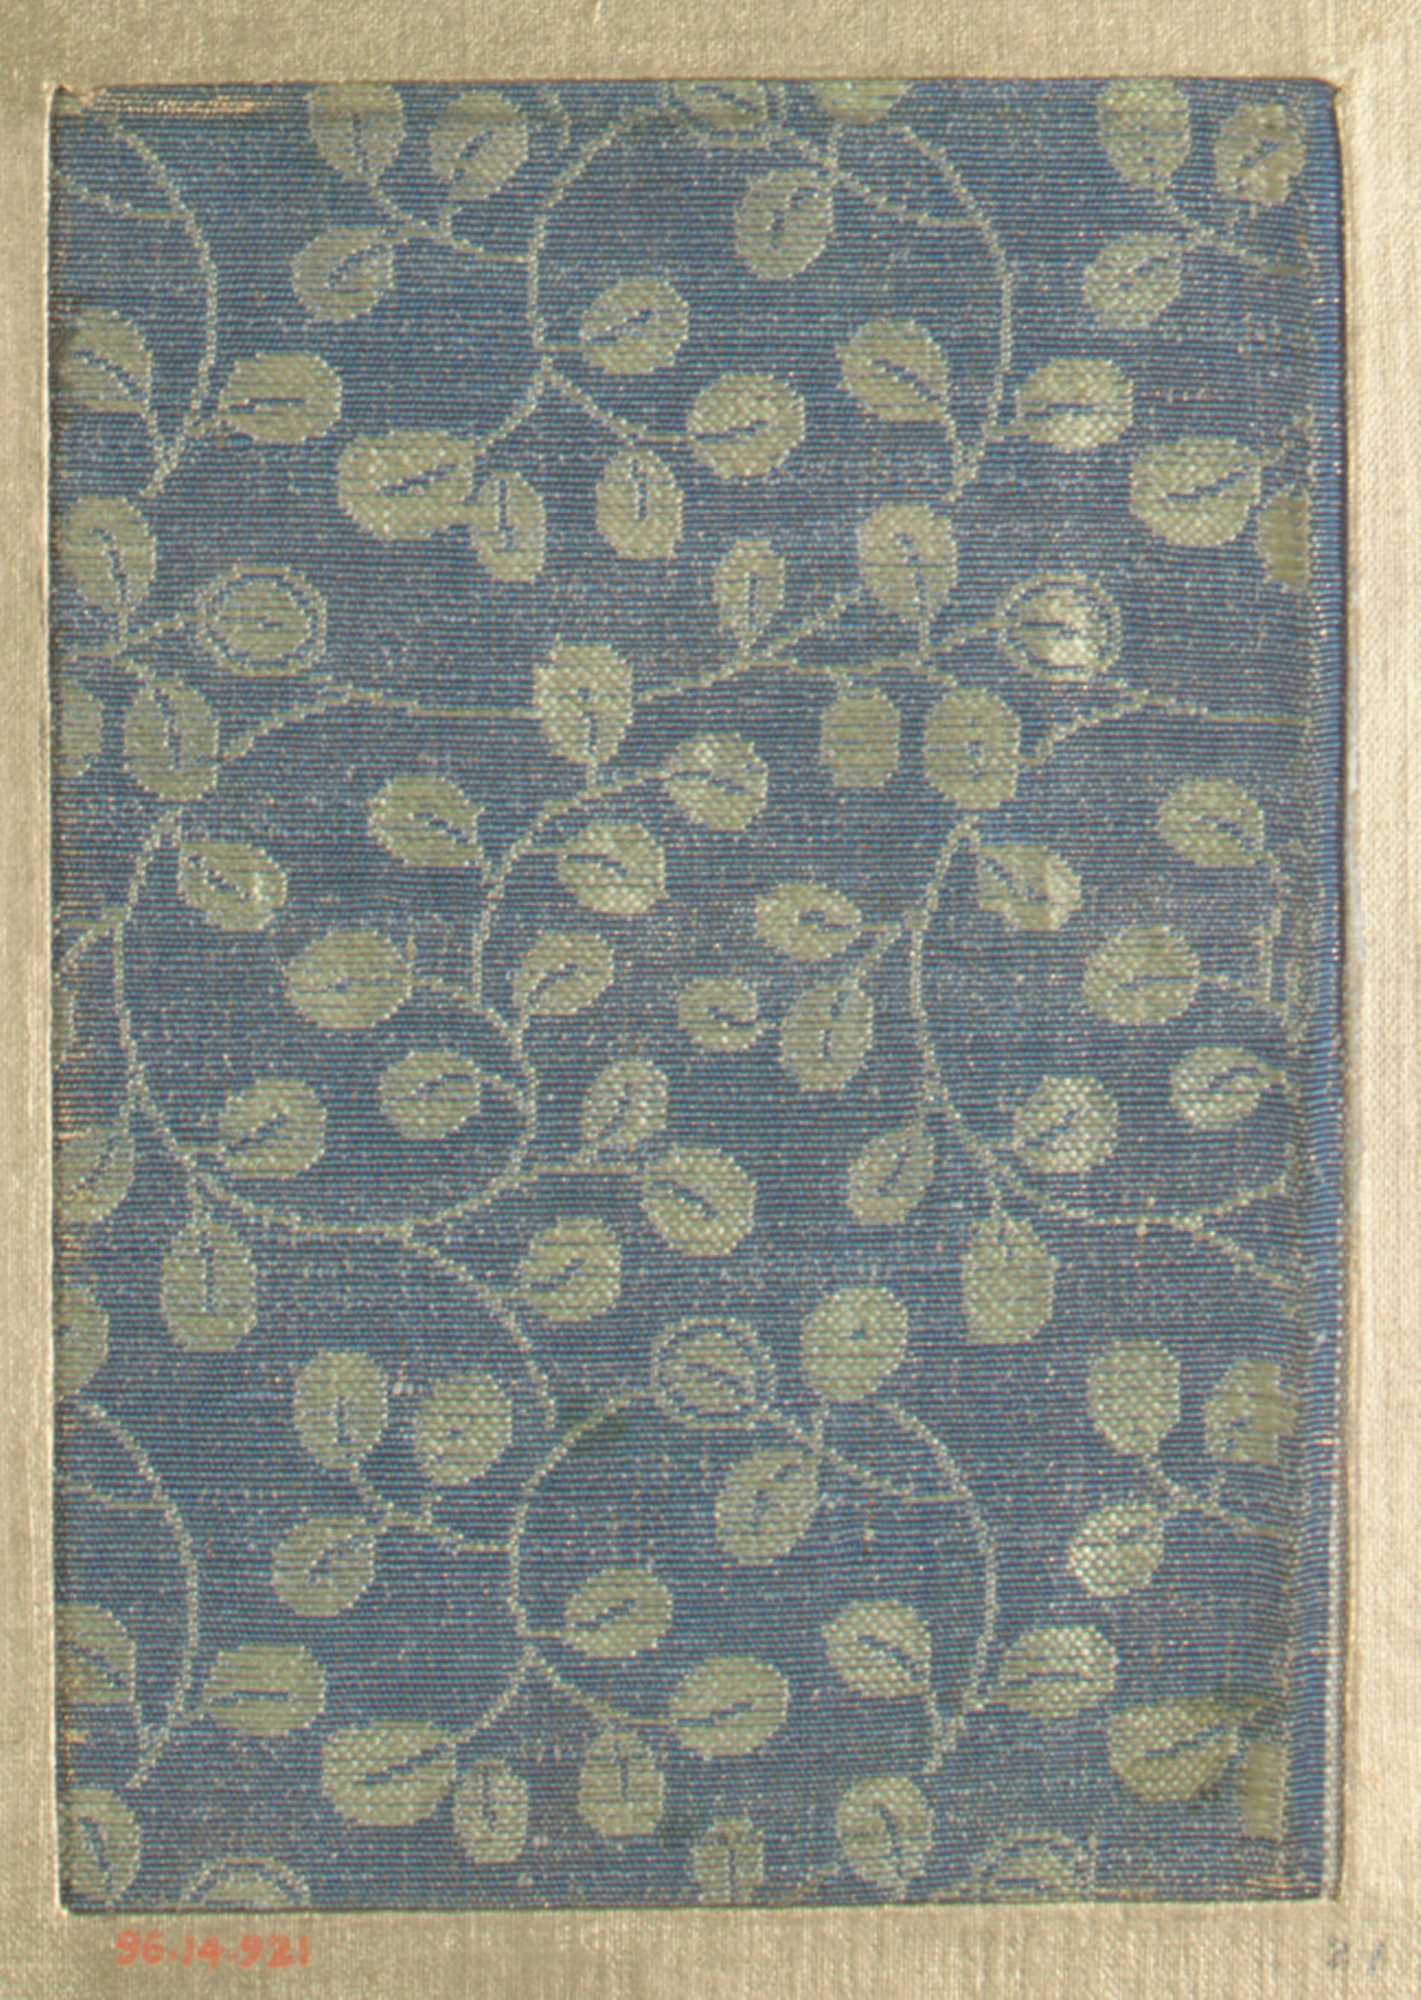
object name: piece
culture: japanese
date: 1701-1900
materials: silk